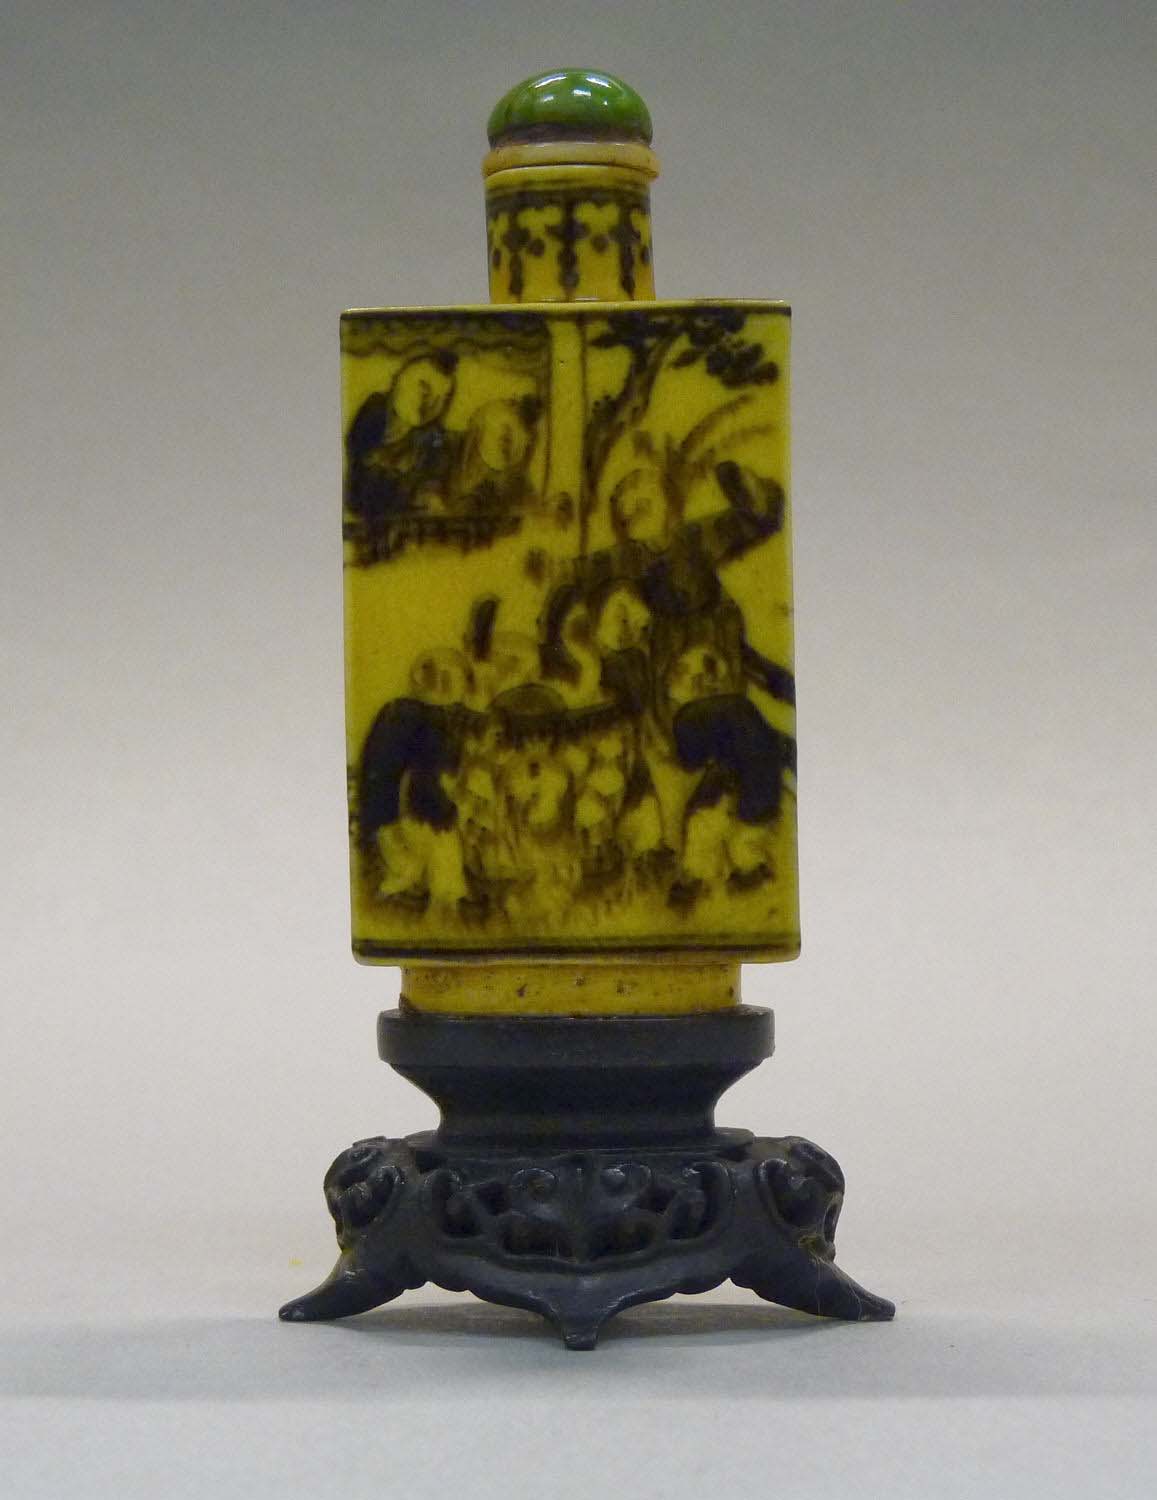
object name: snuff bottle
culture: chinese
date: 1736-1795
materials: porcelain, stone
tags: human figures